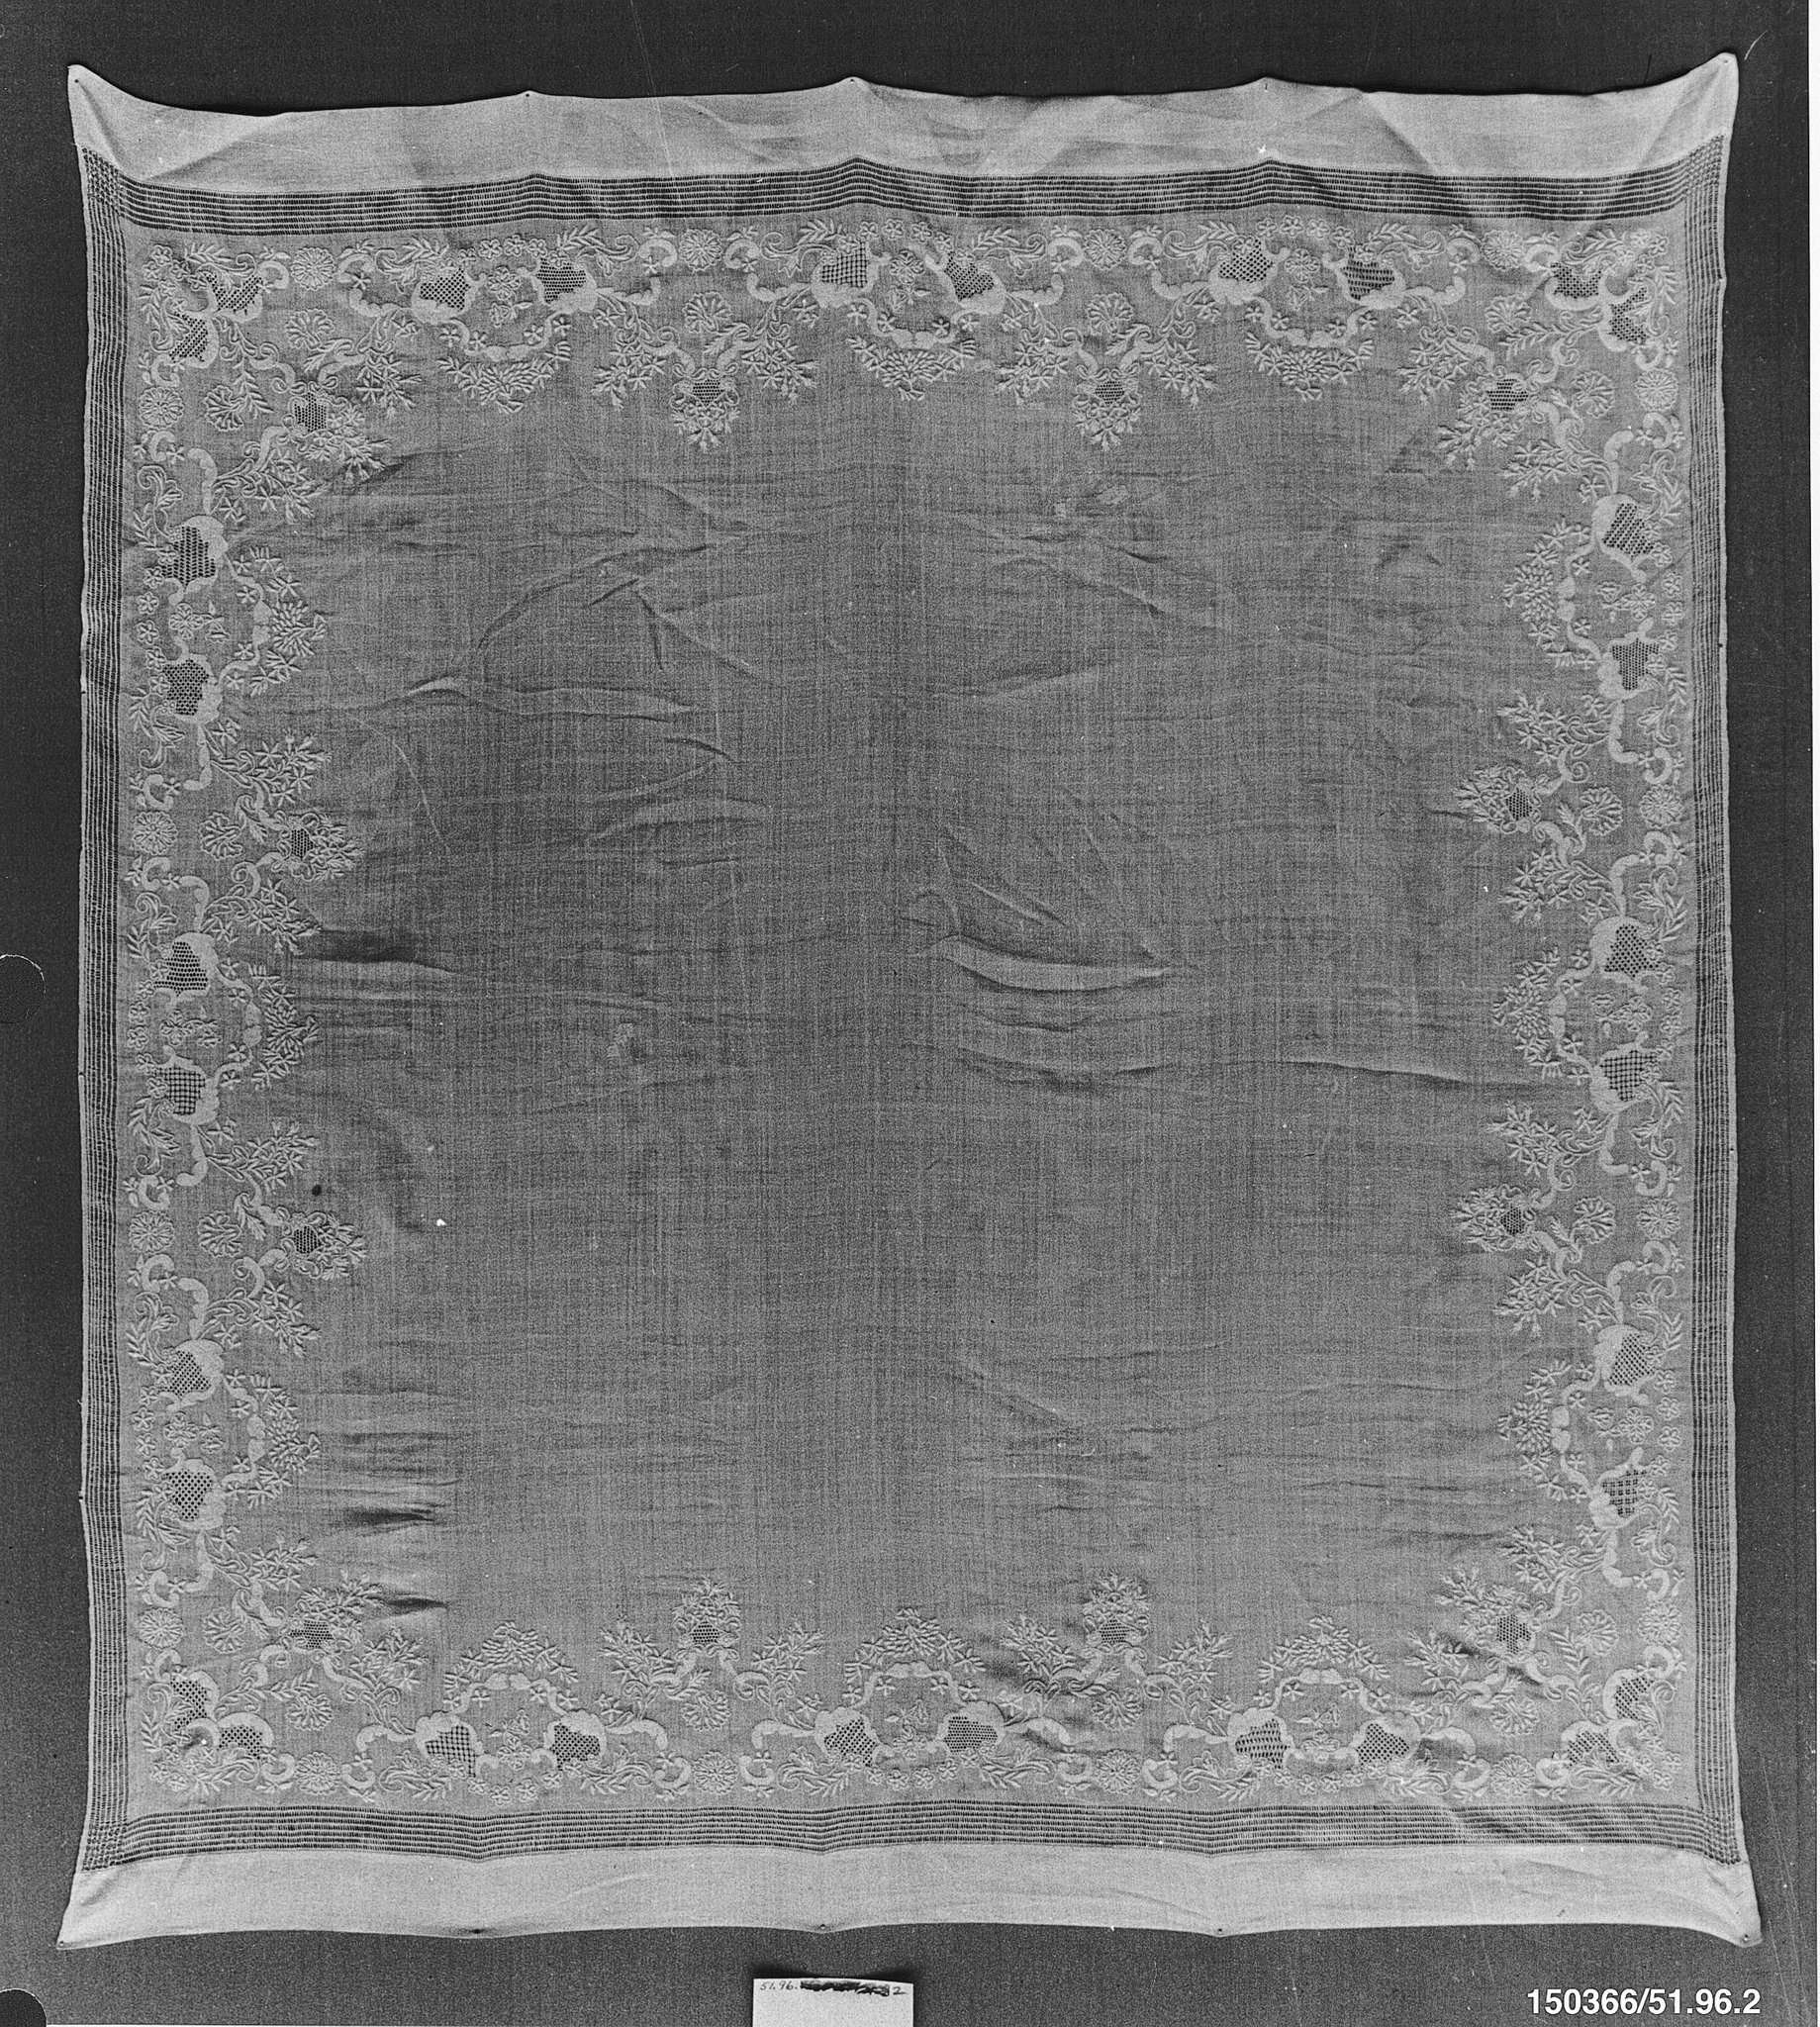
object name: cover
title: Covers (set of three)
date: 1801-1833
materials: cotton, silk